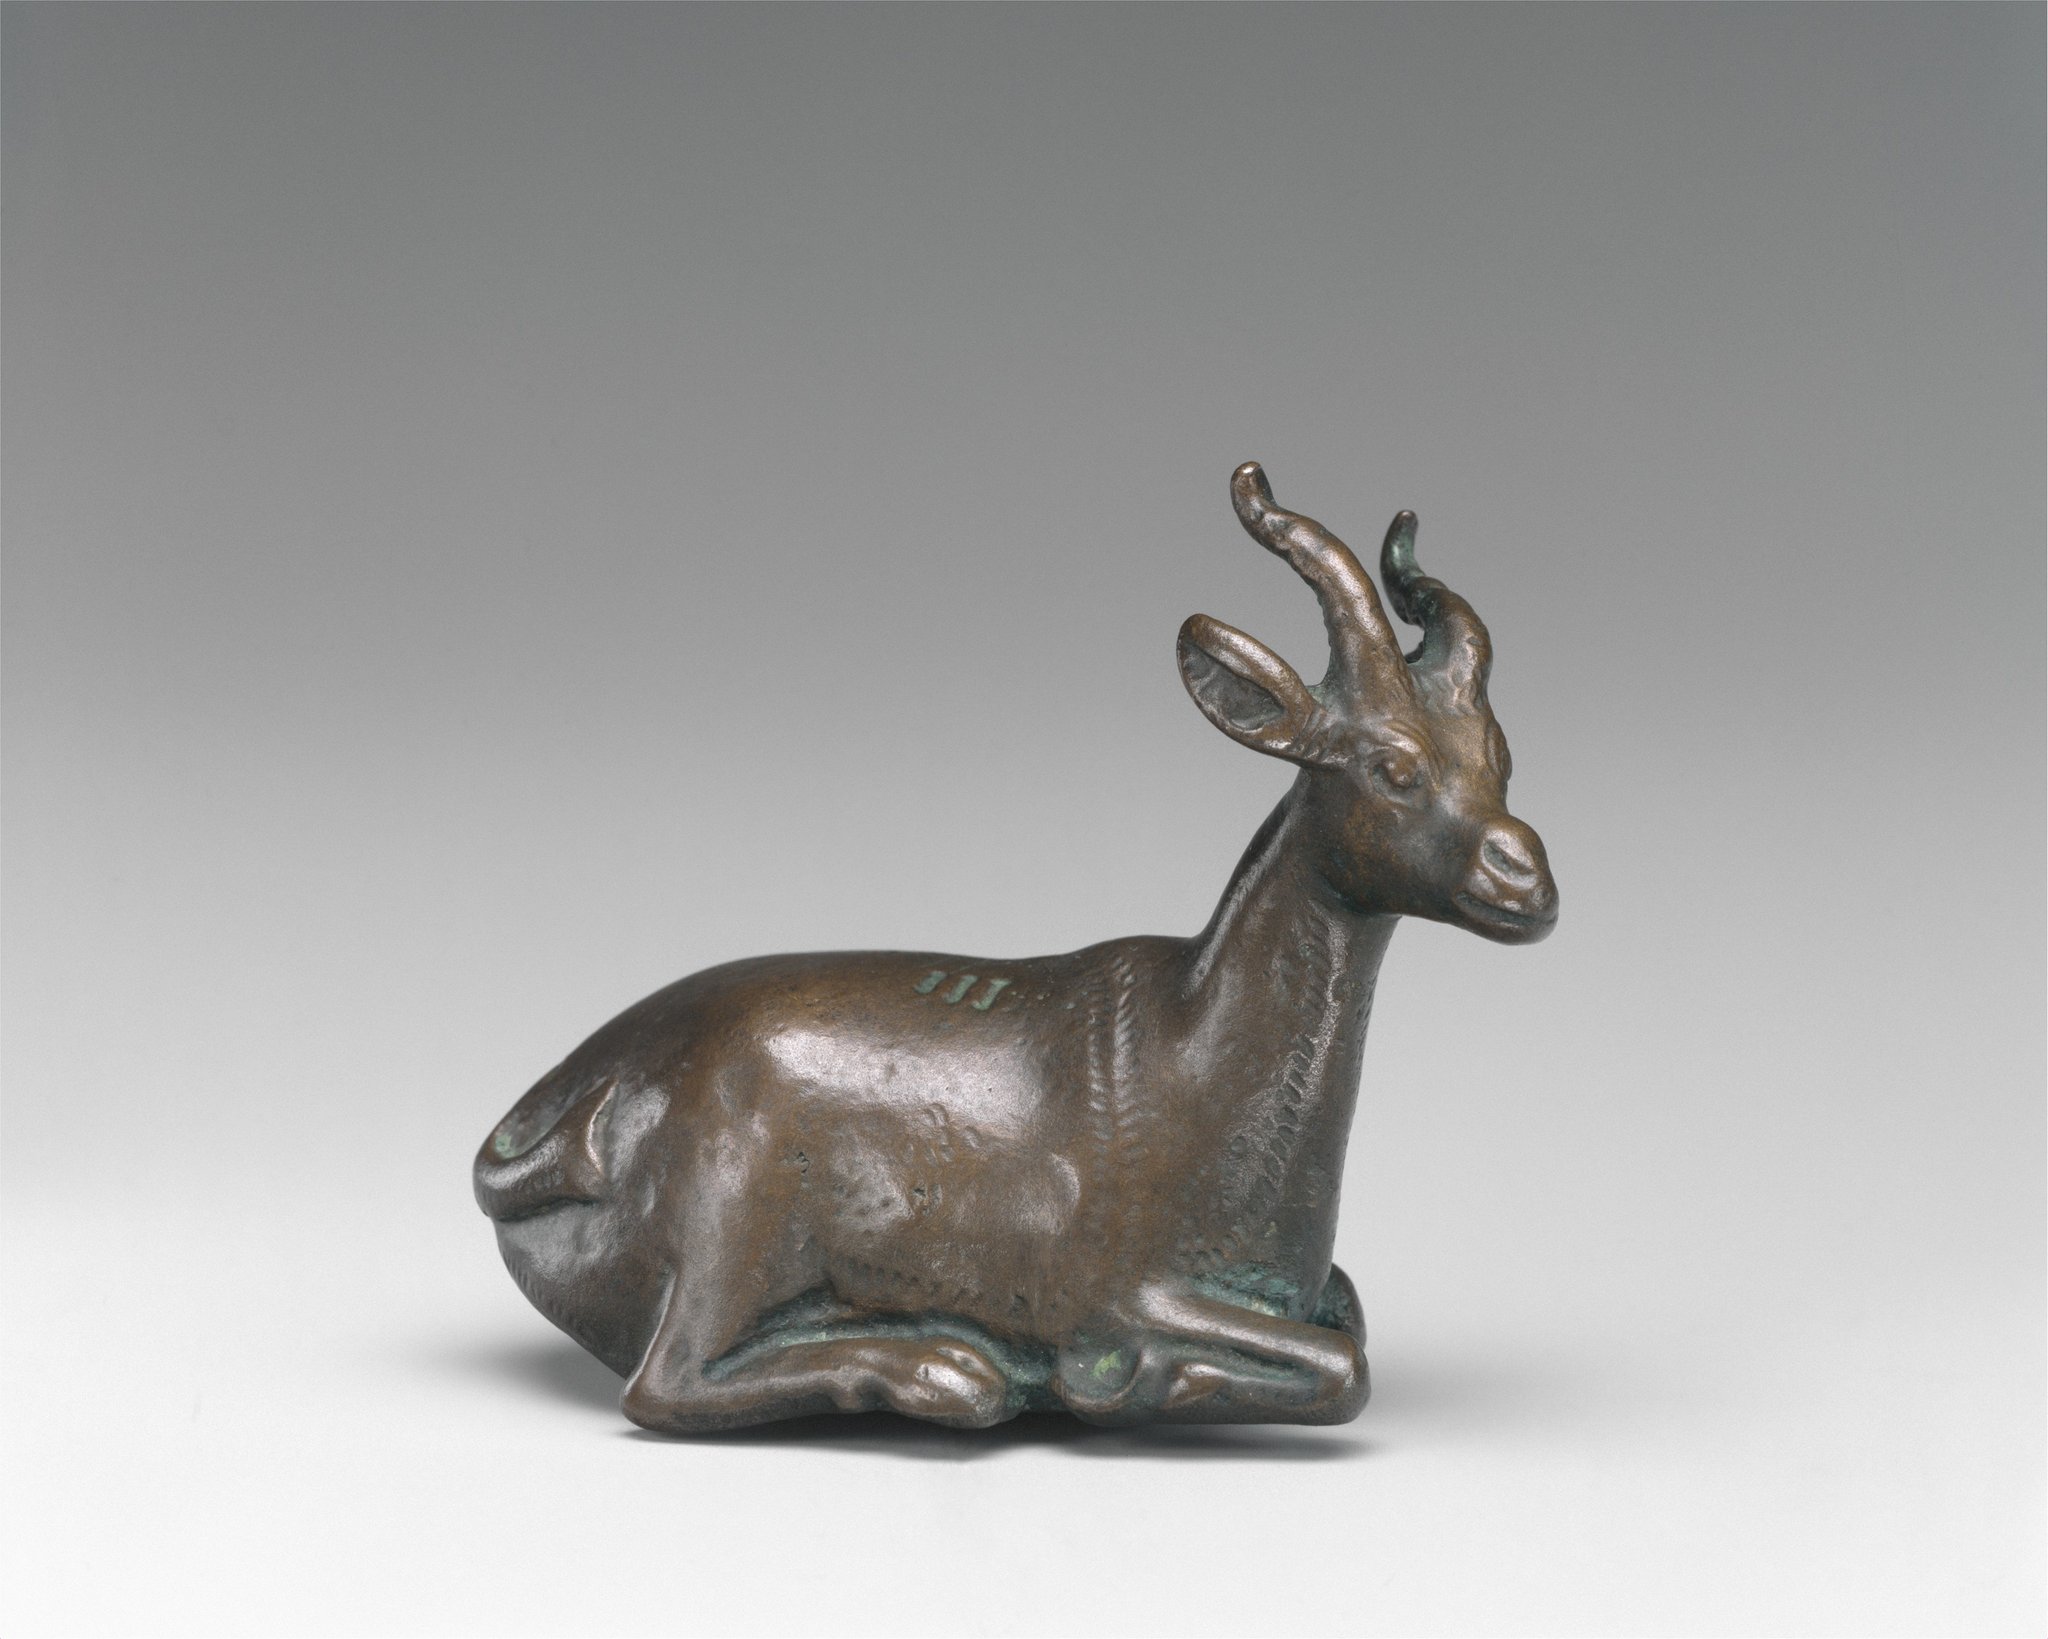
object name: weight, 3 deben, gazelle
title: Weight of 3 Deben in the Shape of a Gazelle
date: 1390-1352 BCE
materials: bronze, copper alloy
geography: egypt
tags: animals